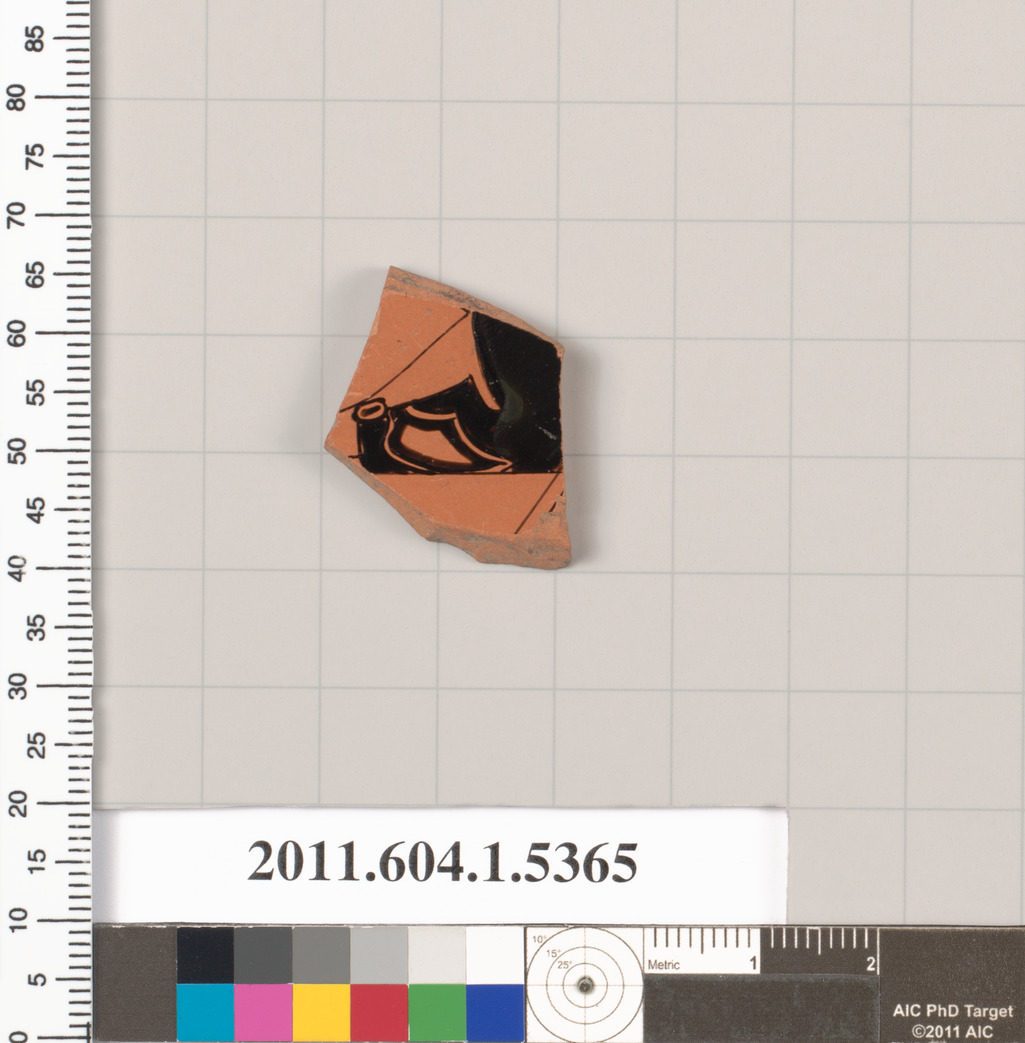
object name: kylix fragment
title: Terracotta fragment of a kylix (drinking cup)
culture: greek, attic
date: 500-480 BCE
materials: terracotta